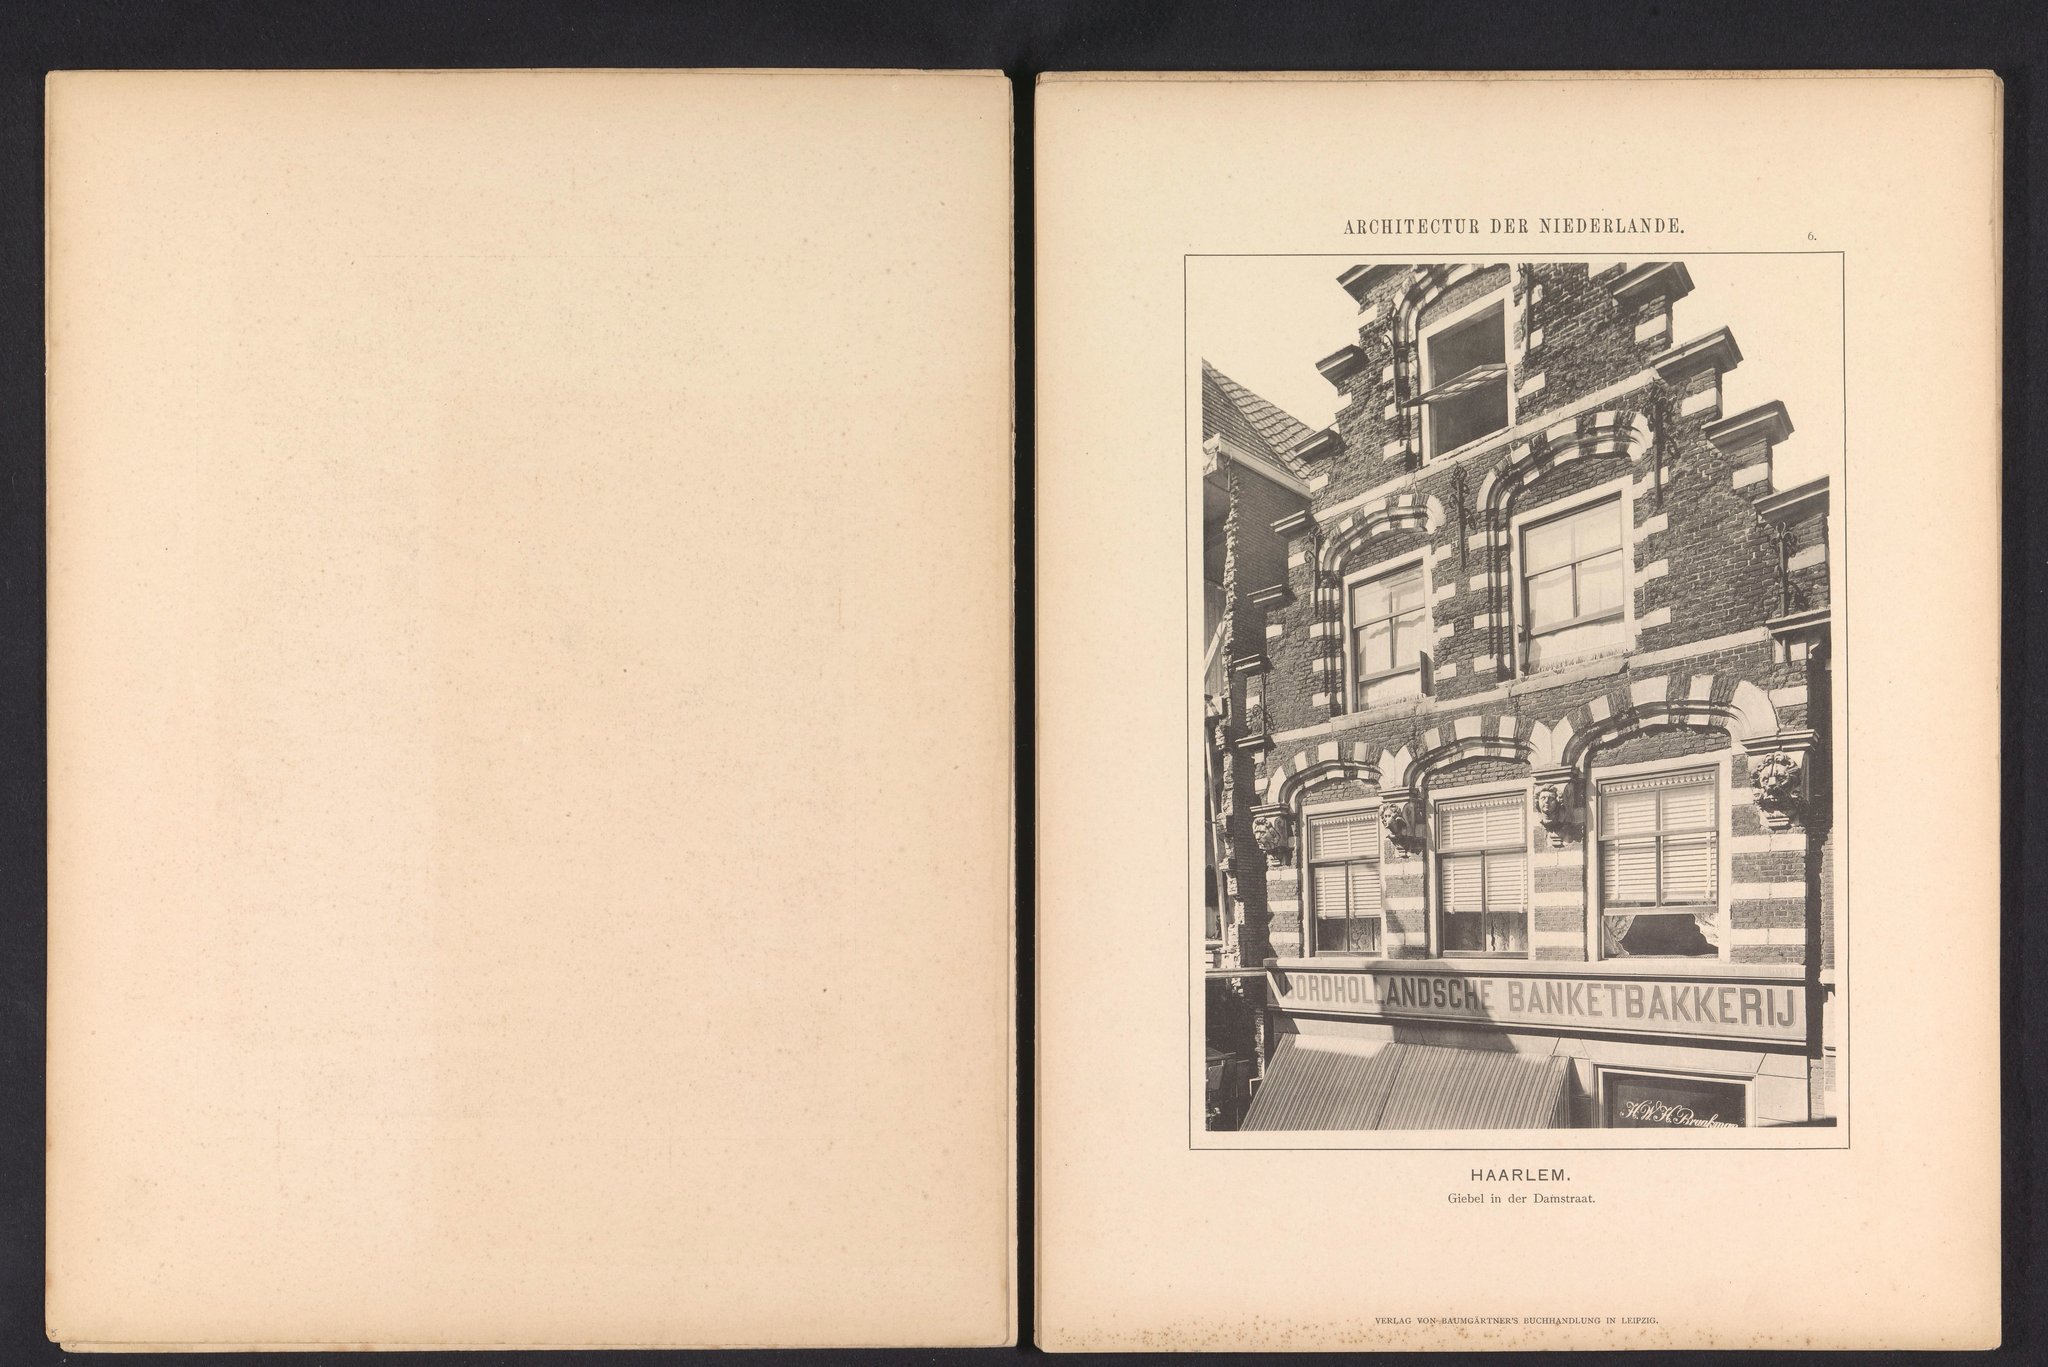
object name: page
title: Gezicht op een trapgevel van een huis aan de Damstraat in Haarlem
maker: Anonymous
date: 1884-1894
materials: paper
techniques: photograph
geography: leipzig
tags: decorated gable, haarlem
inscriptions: number: ‘6.’